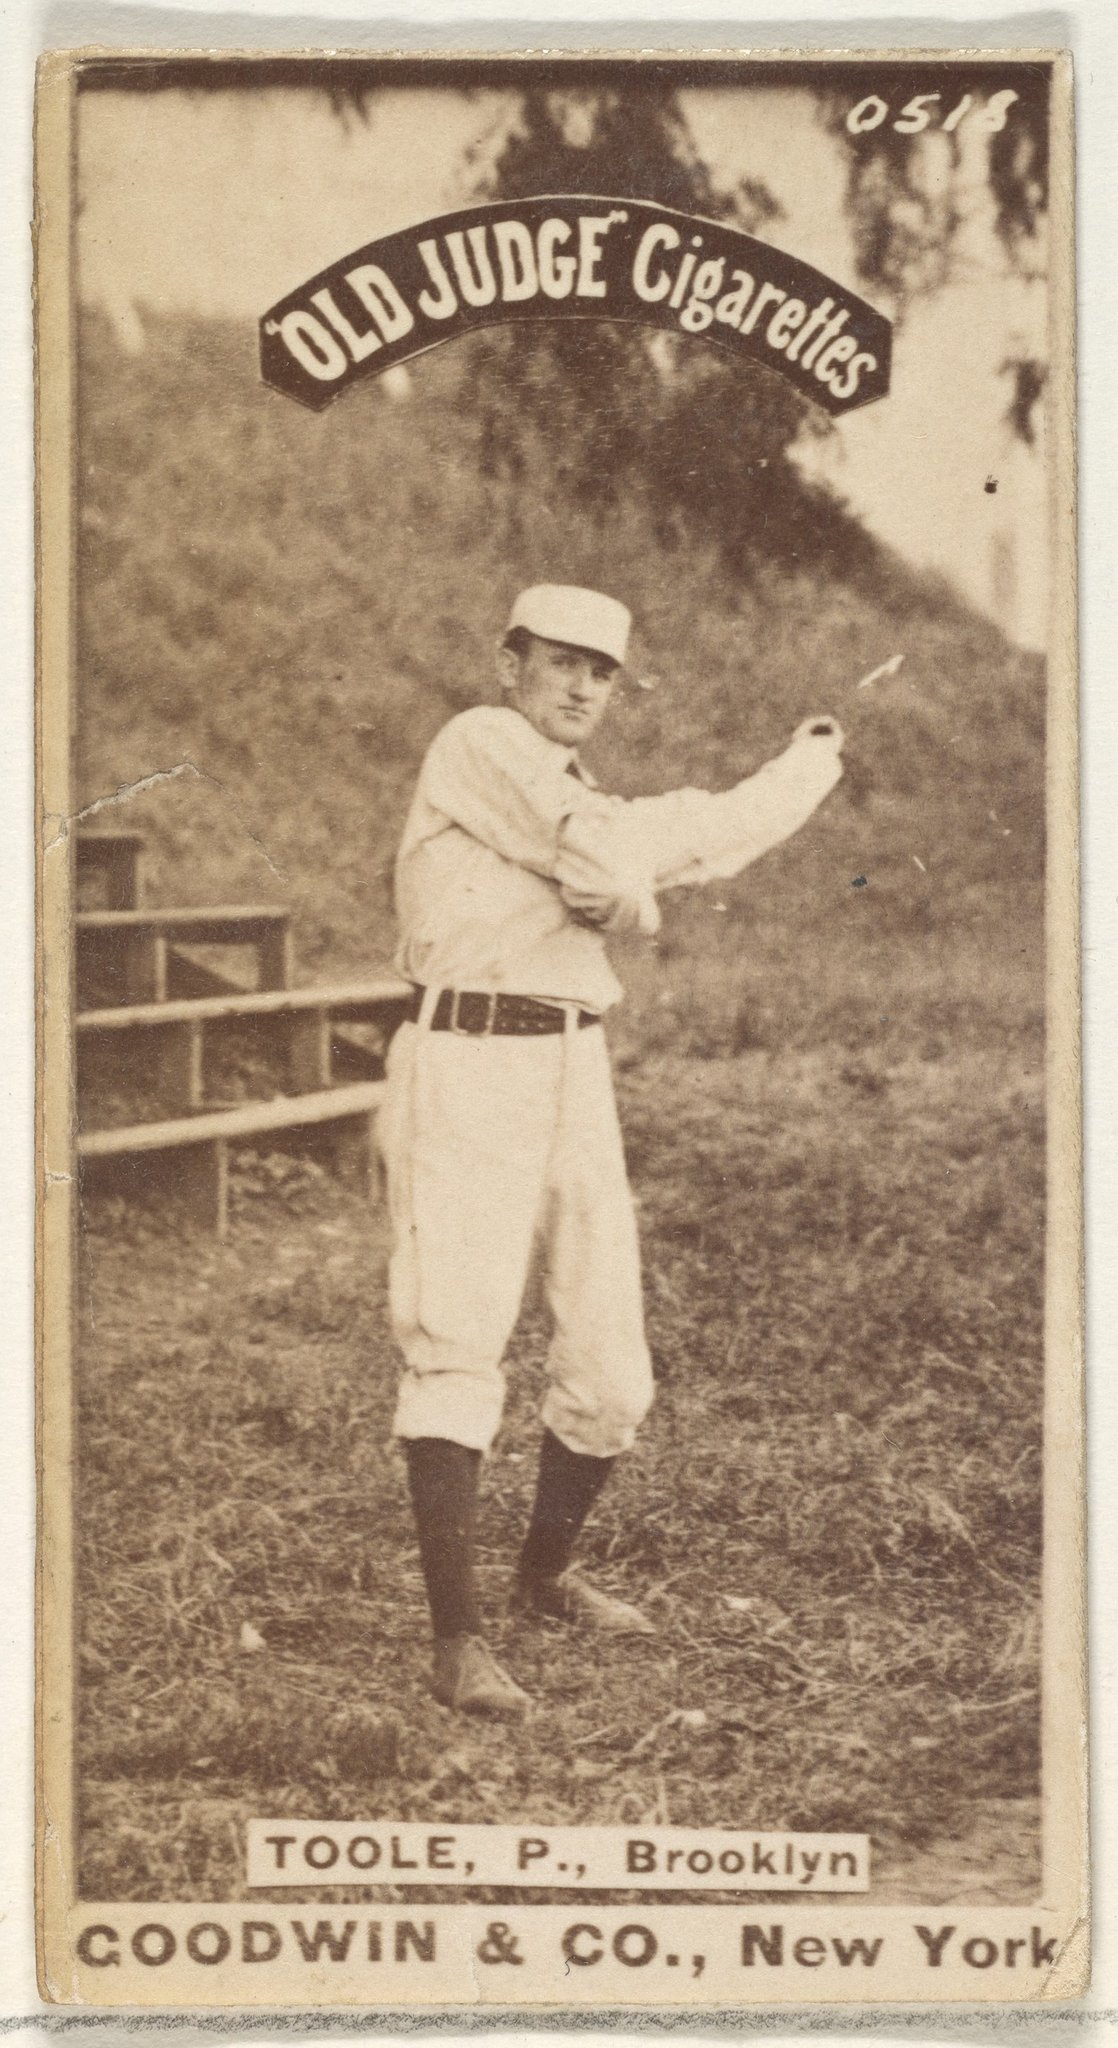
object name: baseball card, photograph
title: Toole, Pitcher, Brooklyn, from the Old Judge series (N172) for Old Judge Cigarettes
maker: goodwin & company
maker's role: publisher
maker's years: 1850-1950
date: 1887-1890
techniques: albumen silver print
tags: men,portraits,baseball,athletes